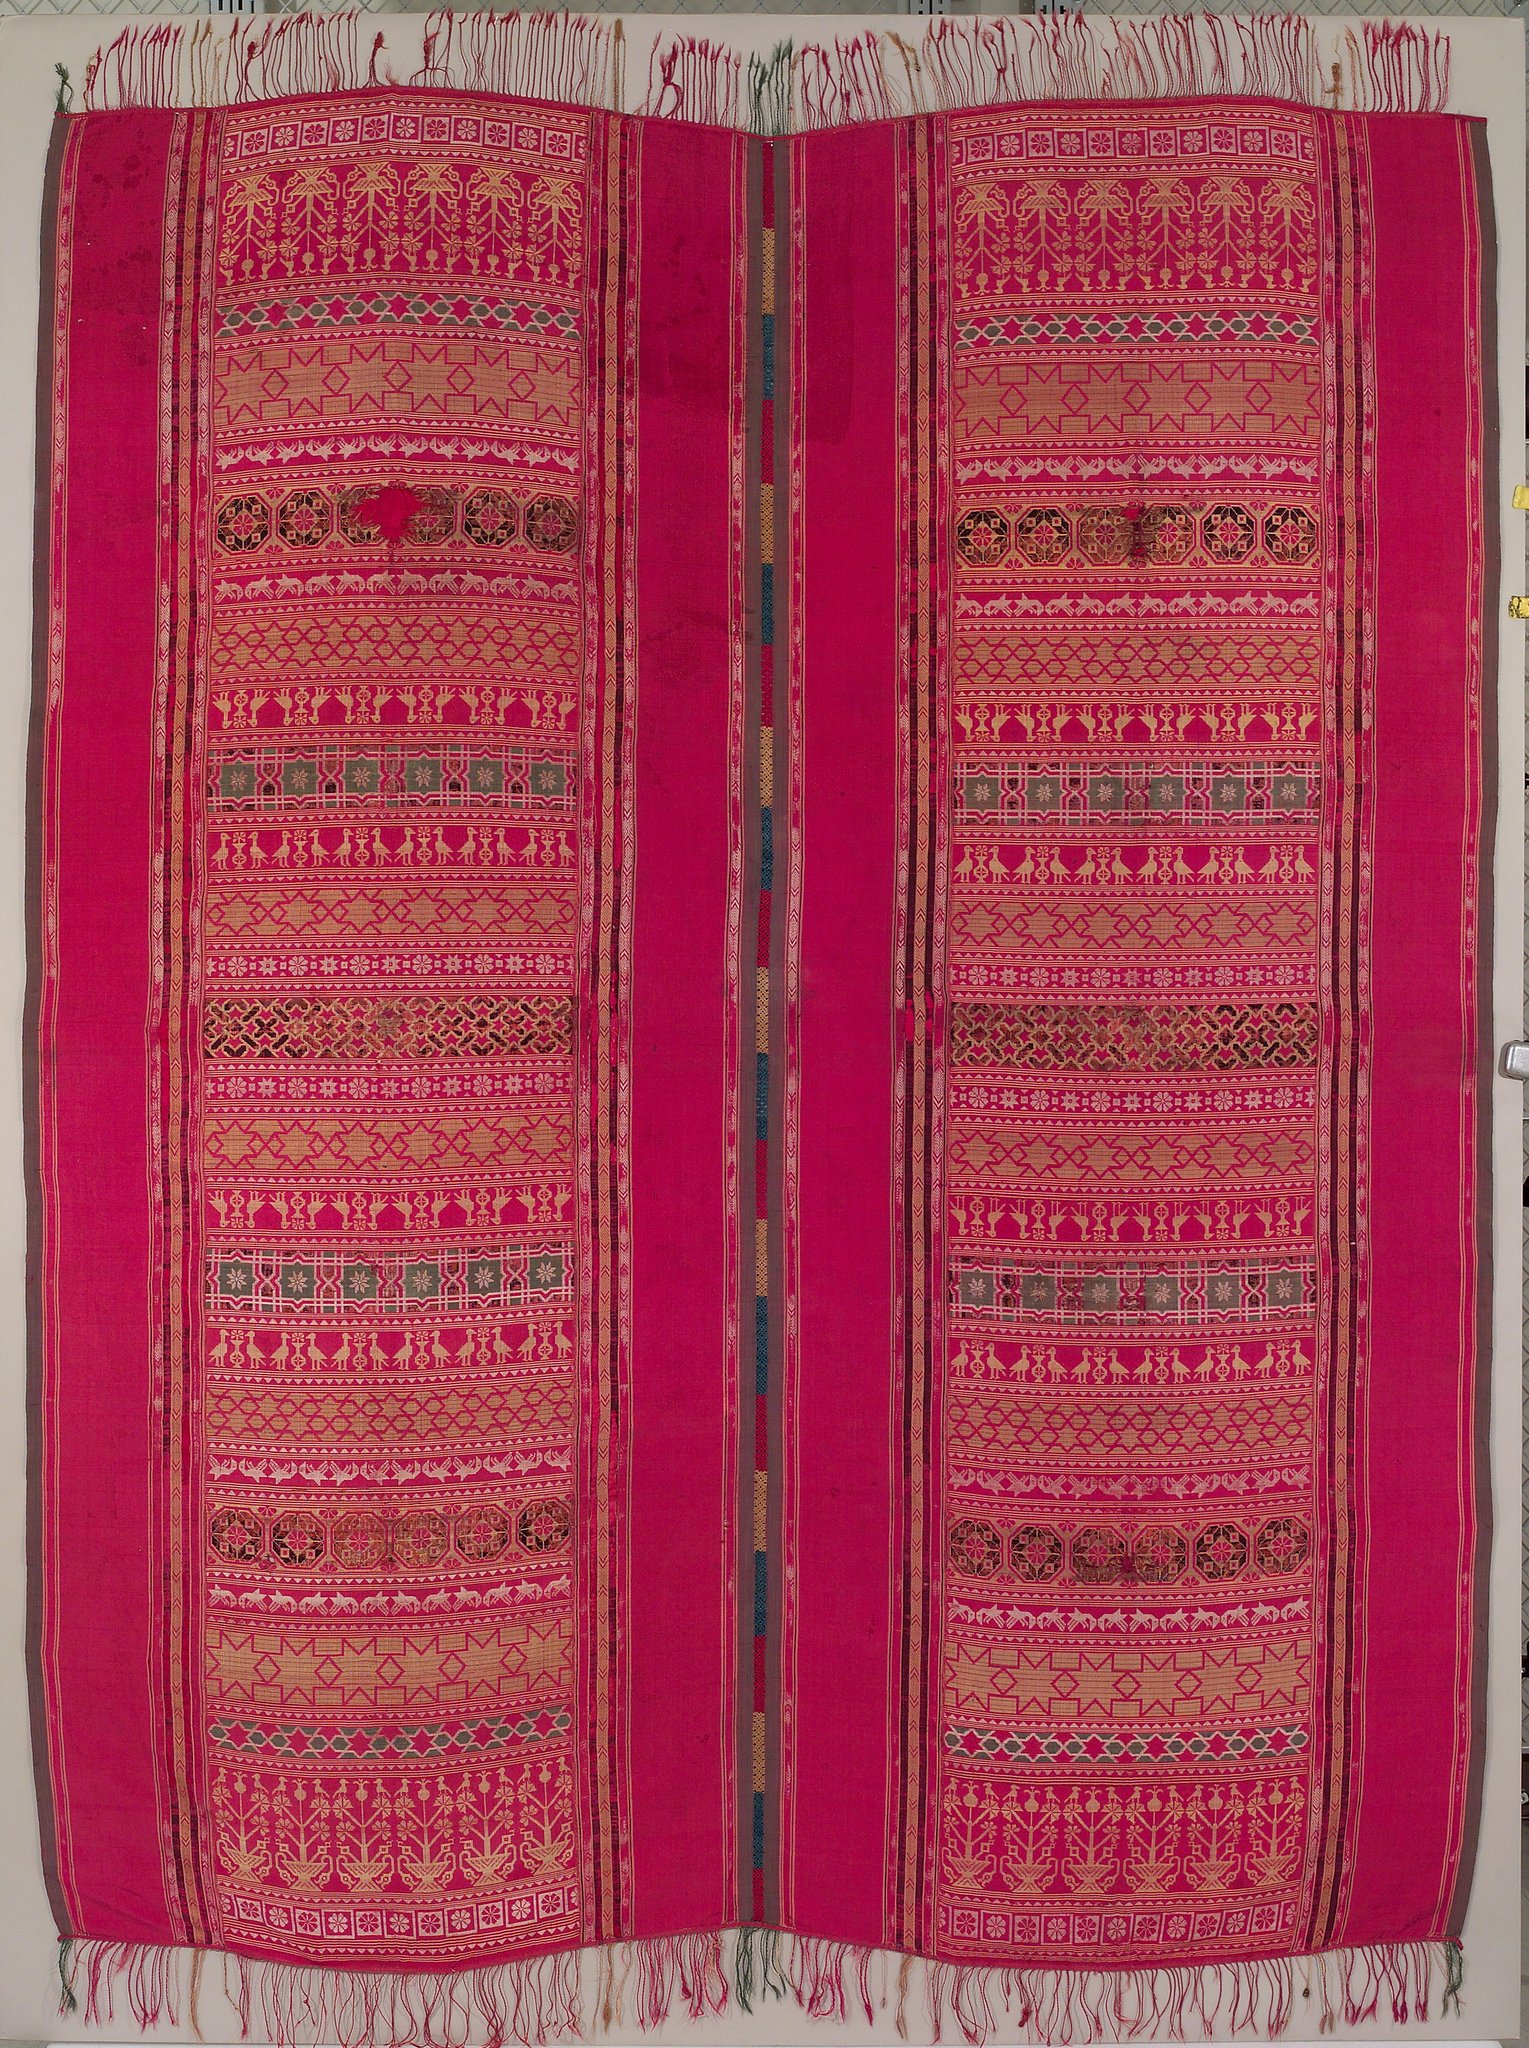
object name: hanging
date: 1701-1800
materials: silk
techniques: damask, weave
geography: tunisia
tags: birds